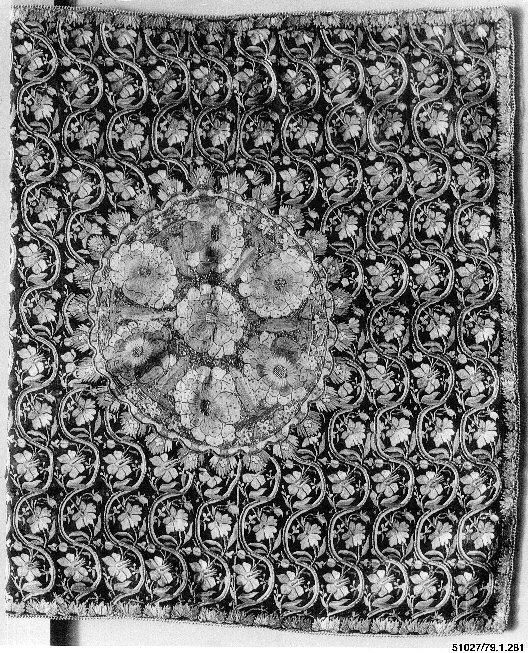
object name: cover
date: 1701-1833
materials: metal thread, silk, wool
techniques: embroidery, weave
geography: turkey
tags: flowers